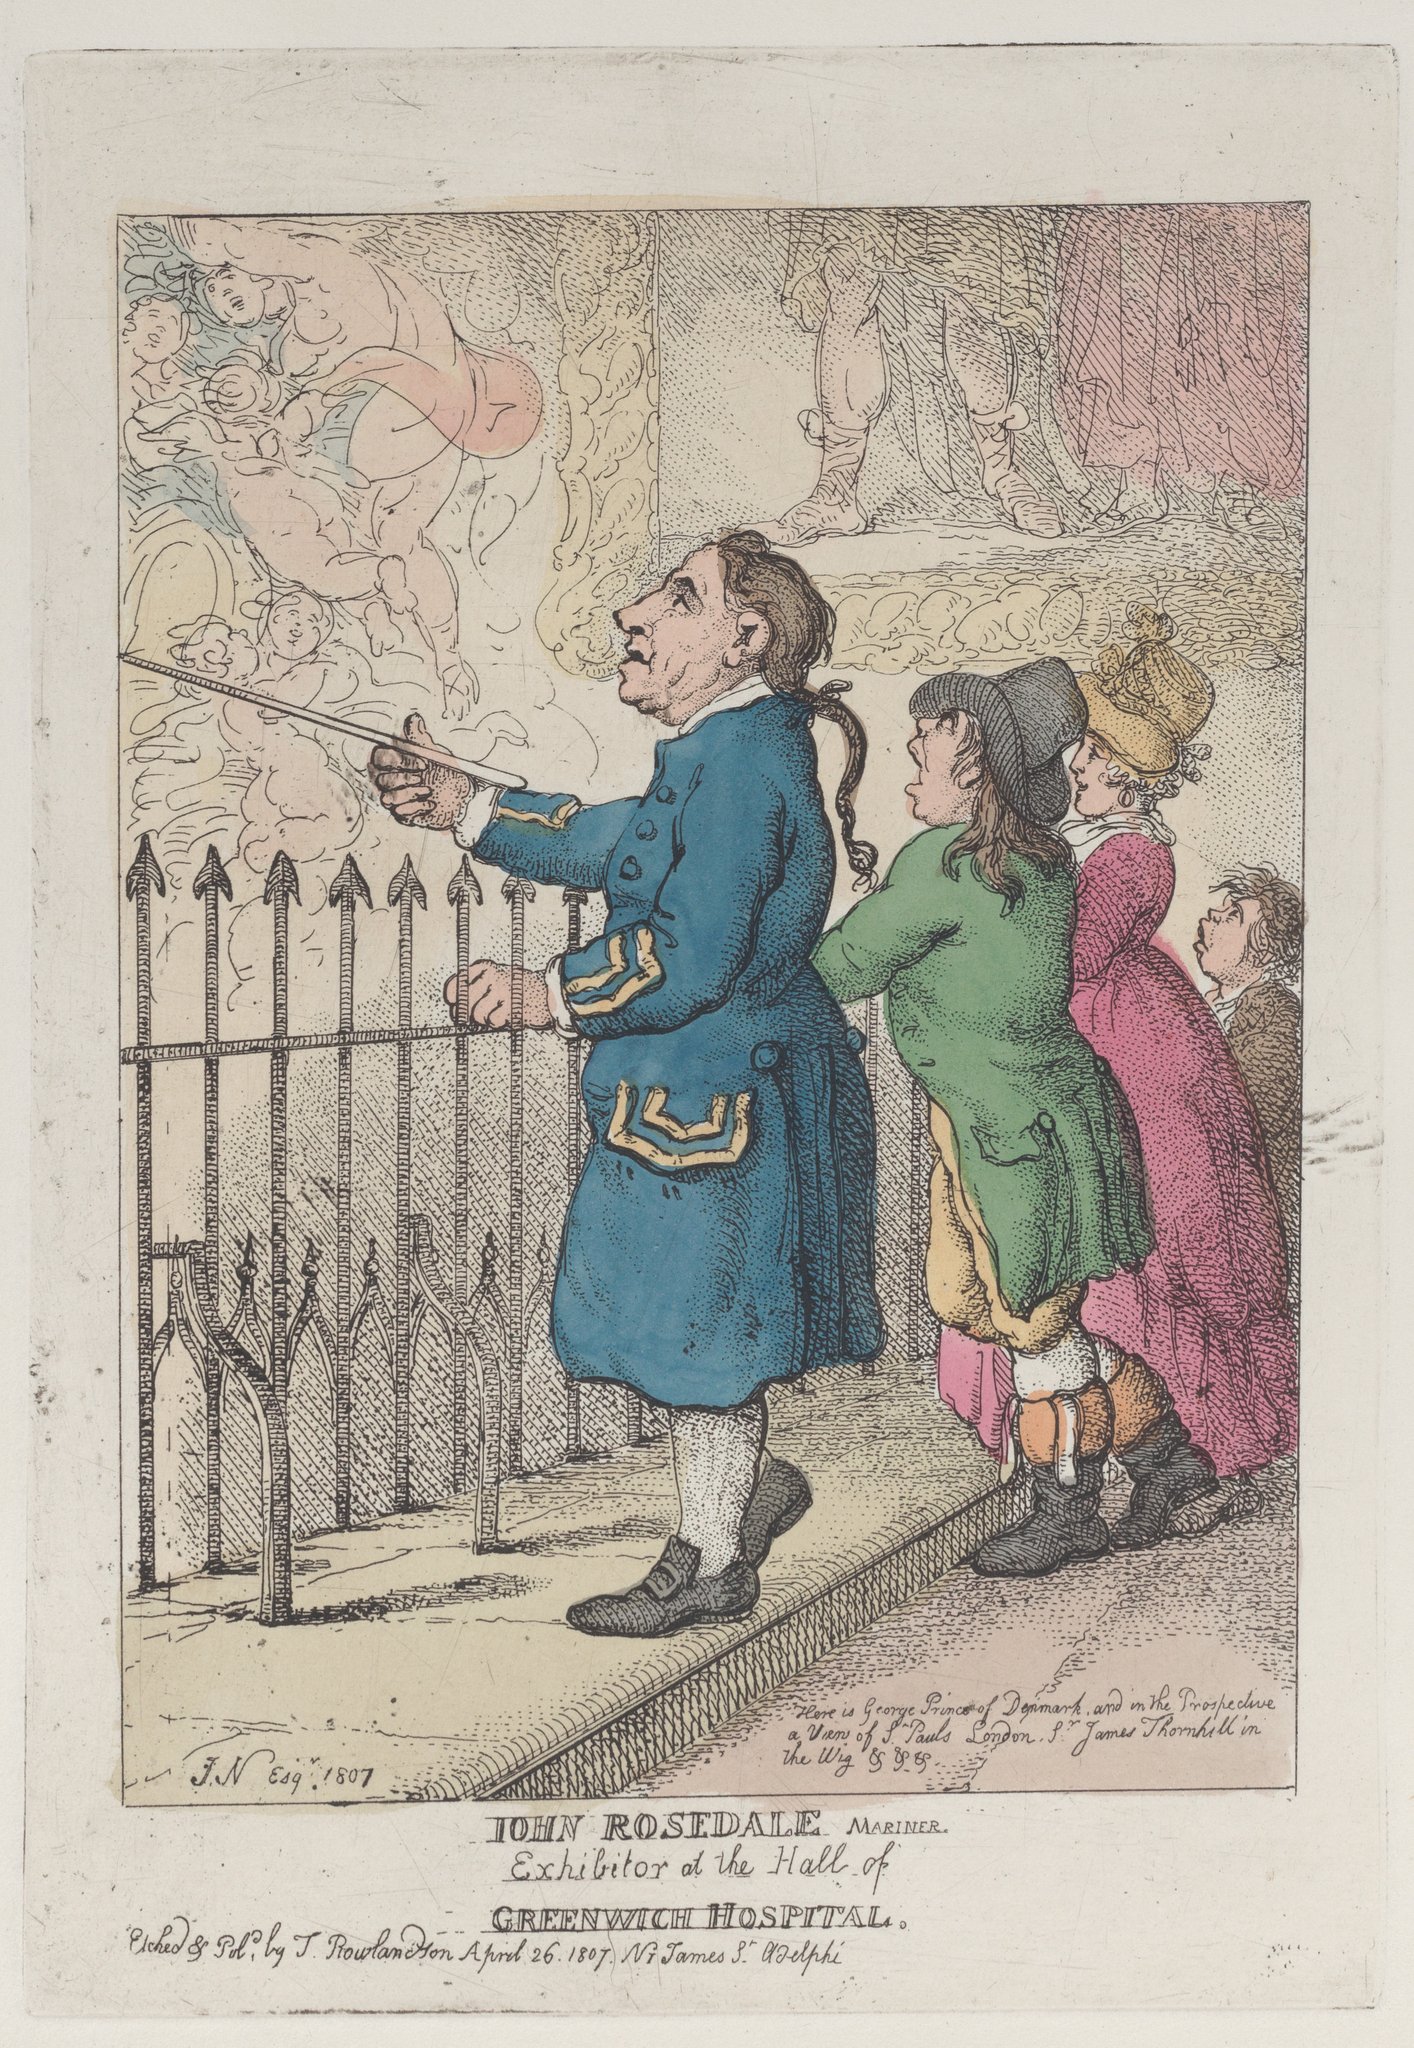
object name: print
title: John Rosedale Mariner, Exhibitor at the Hall of Greenwich Hospital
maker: thomas rowlandson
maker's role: artist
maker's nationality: british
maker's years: 1757-1827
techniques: etching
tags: satire,men,women